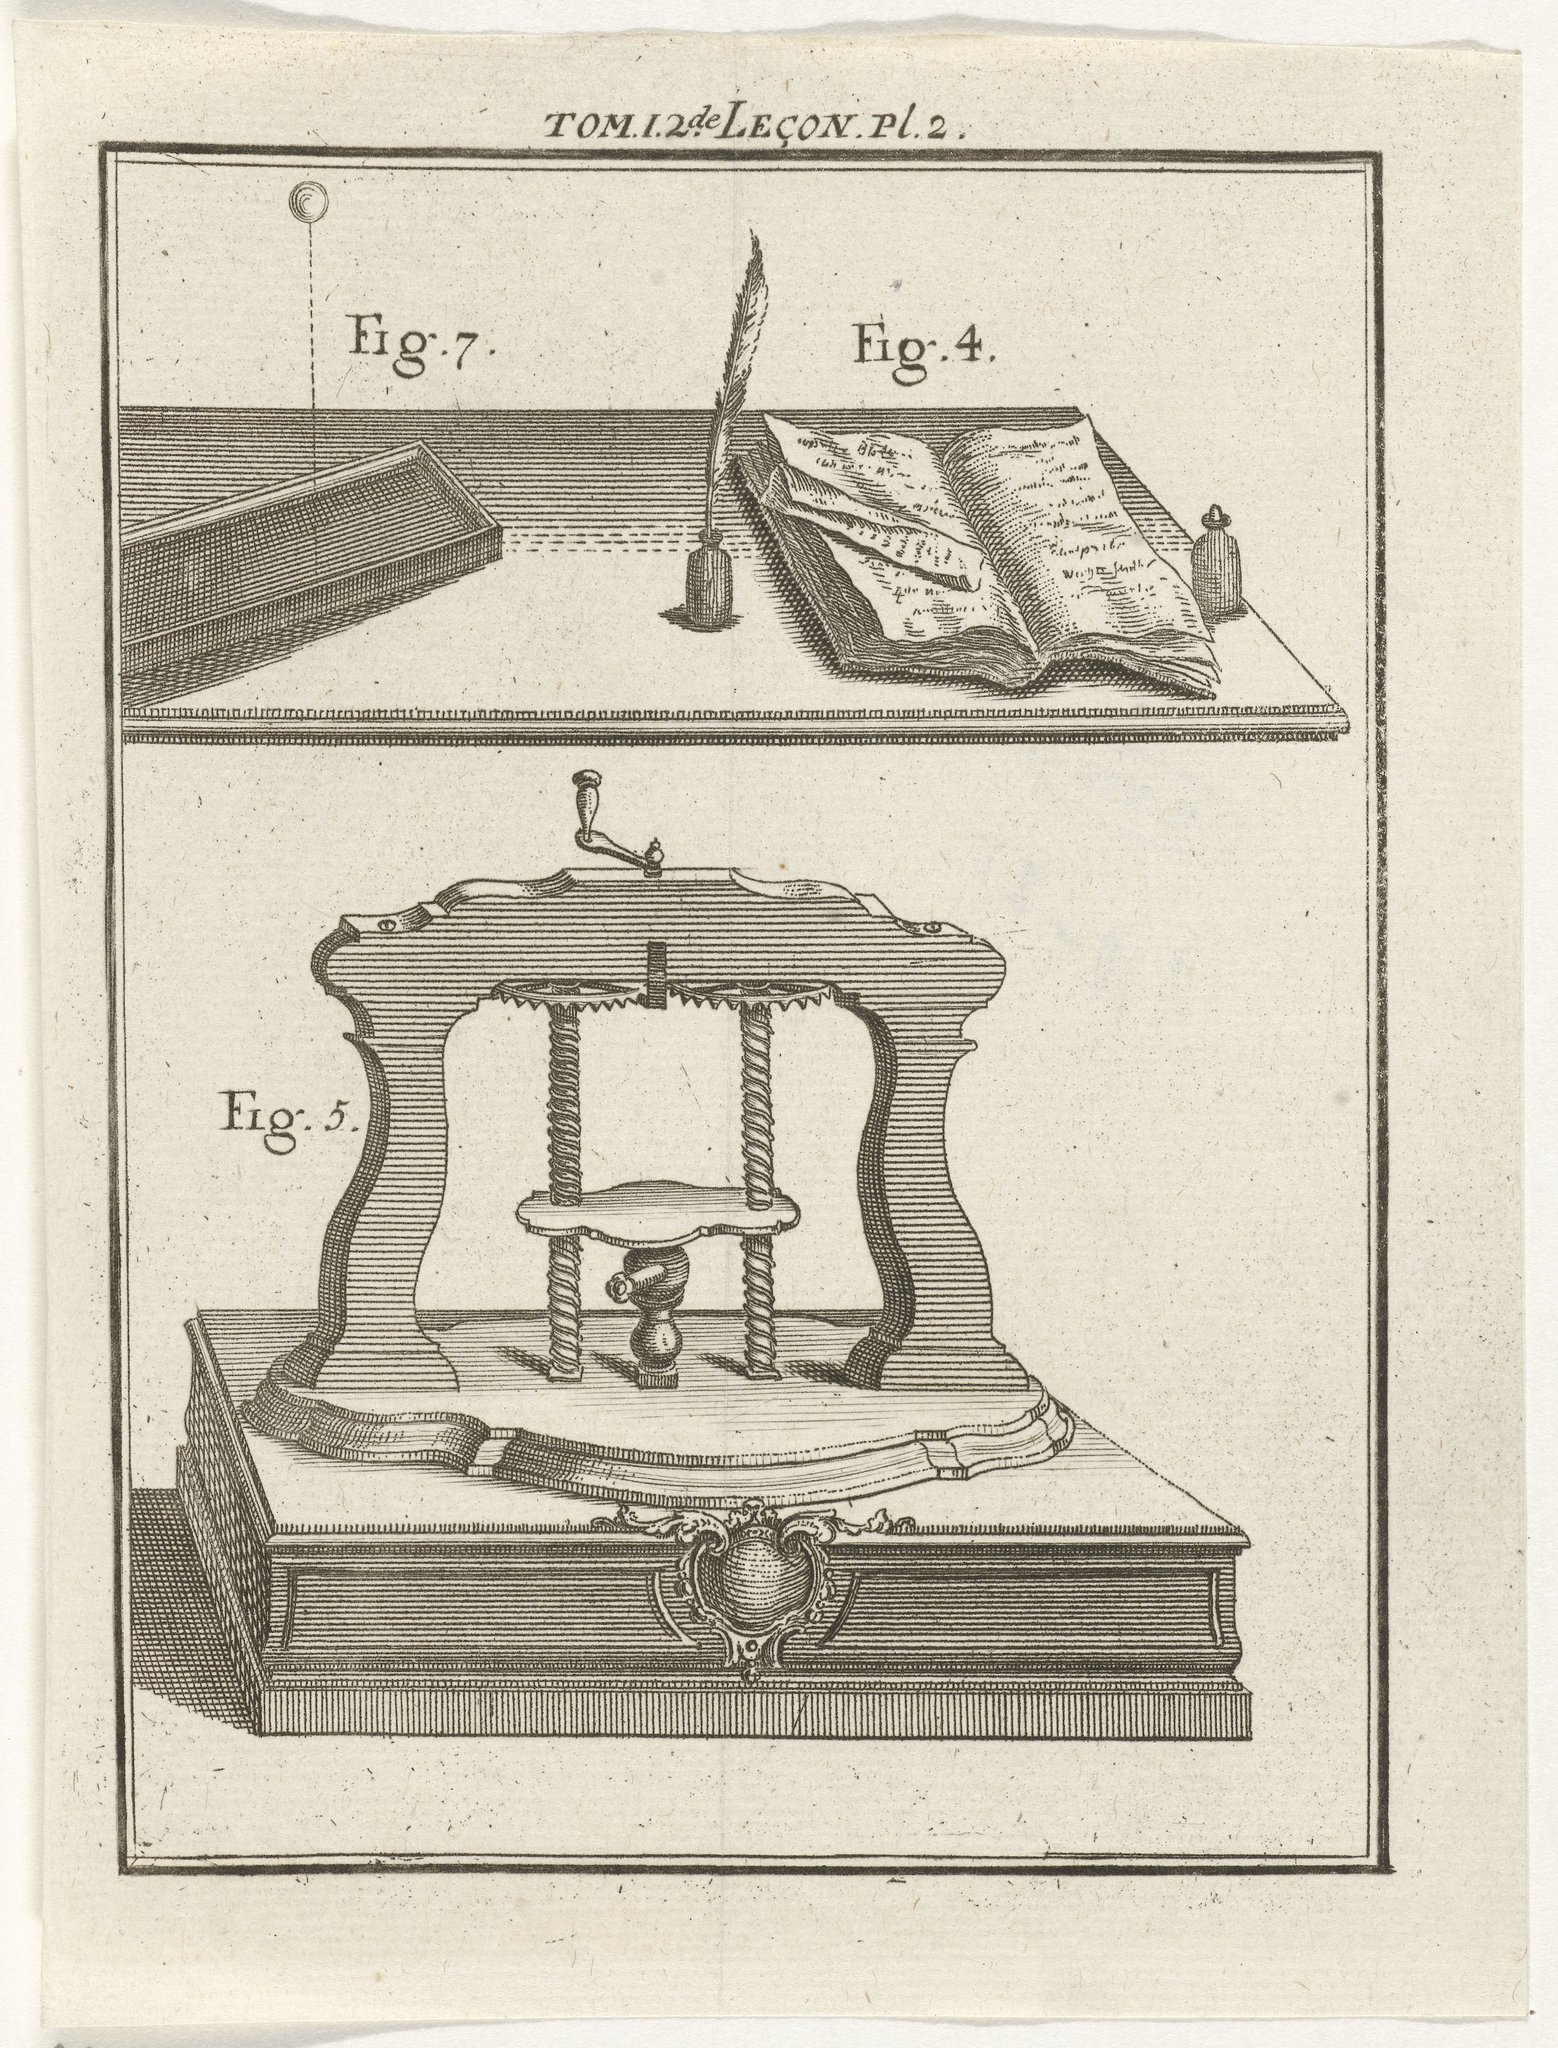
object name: print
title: Voorwerpen voor natuurkundig onderzoek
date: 1759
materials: paper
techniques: etching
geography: amsterdam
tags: physics (+ tools, instruments; laboratory equipment ~ scientific research)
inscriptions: collector's mark: Lugt 2228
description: Weergave van voorwerpen die gebruikt worden bij natuurkundig onderzoek, voorzien van nummers. Prent middenboven gemerkt: Tom. I.2de Leçon. Pl. 2.